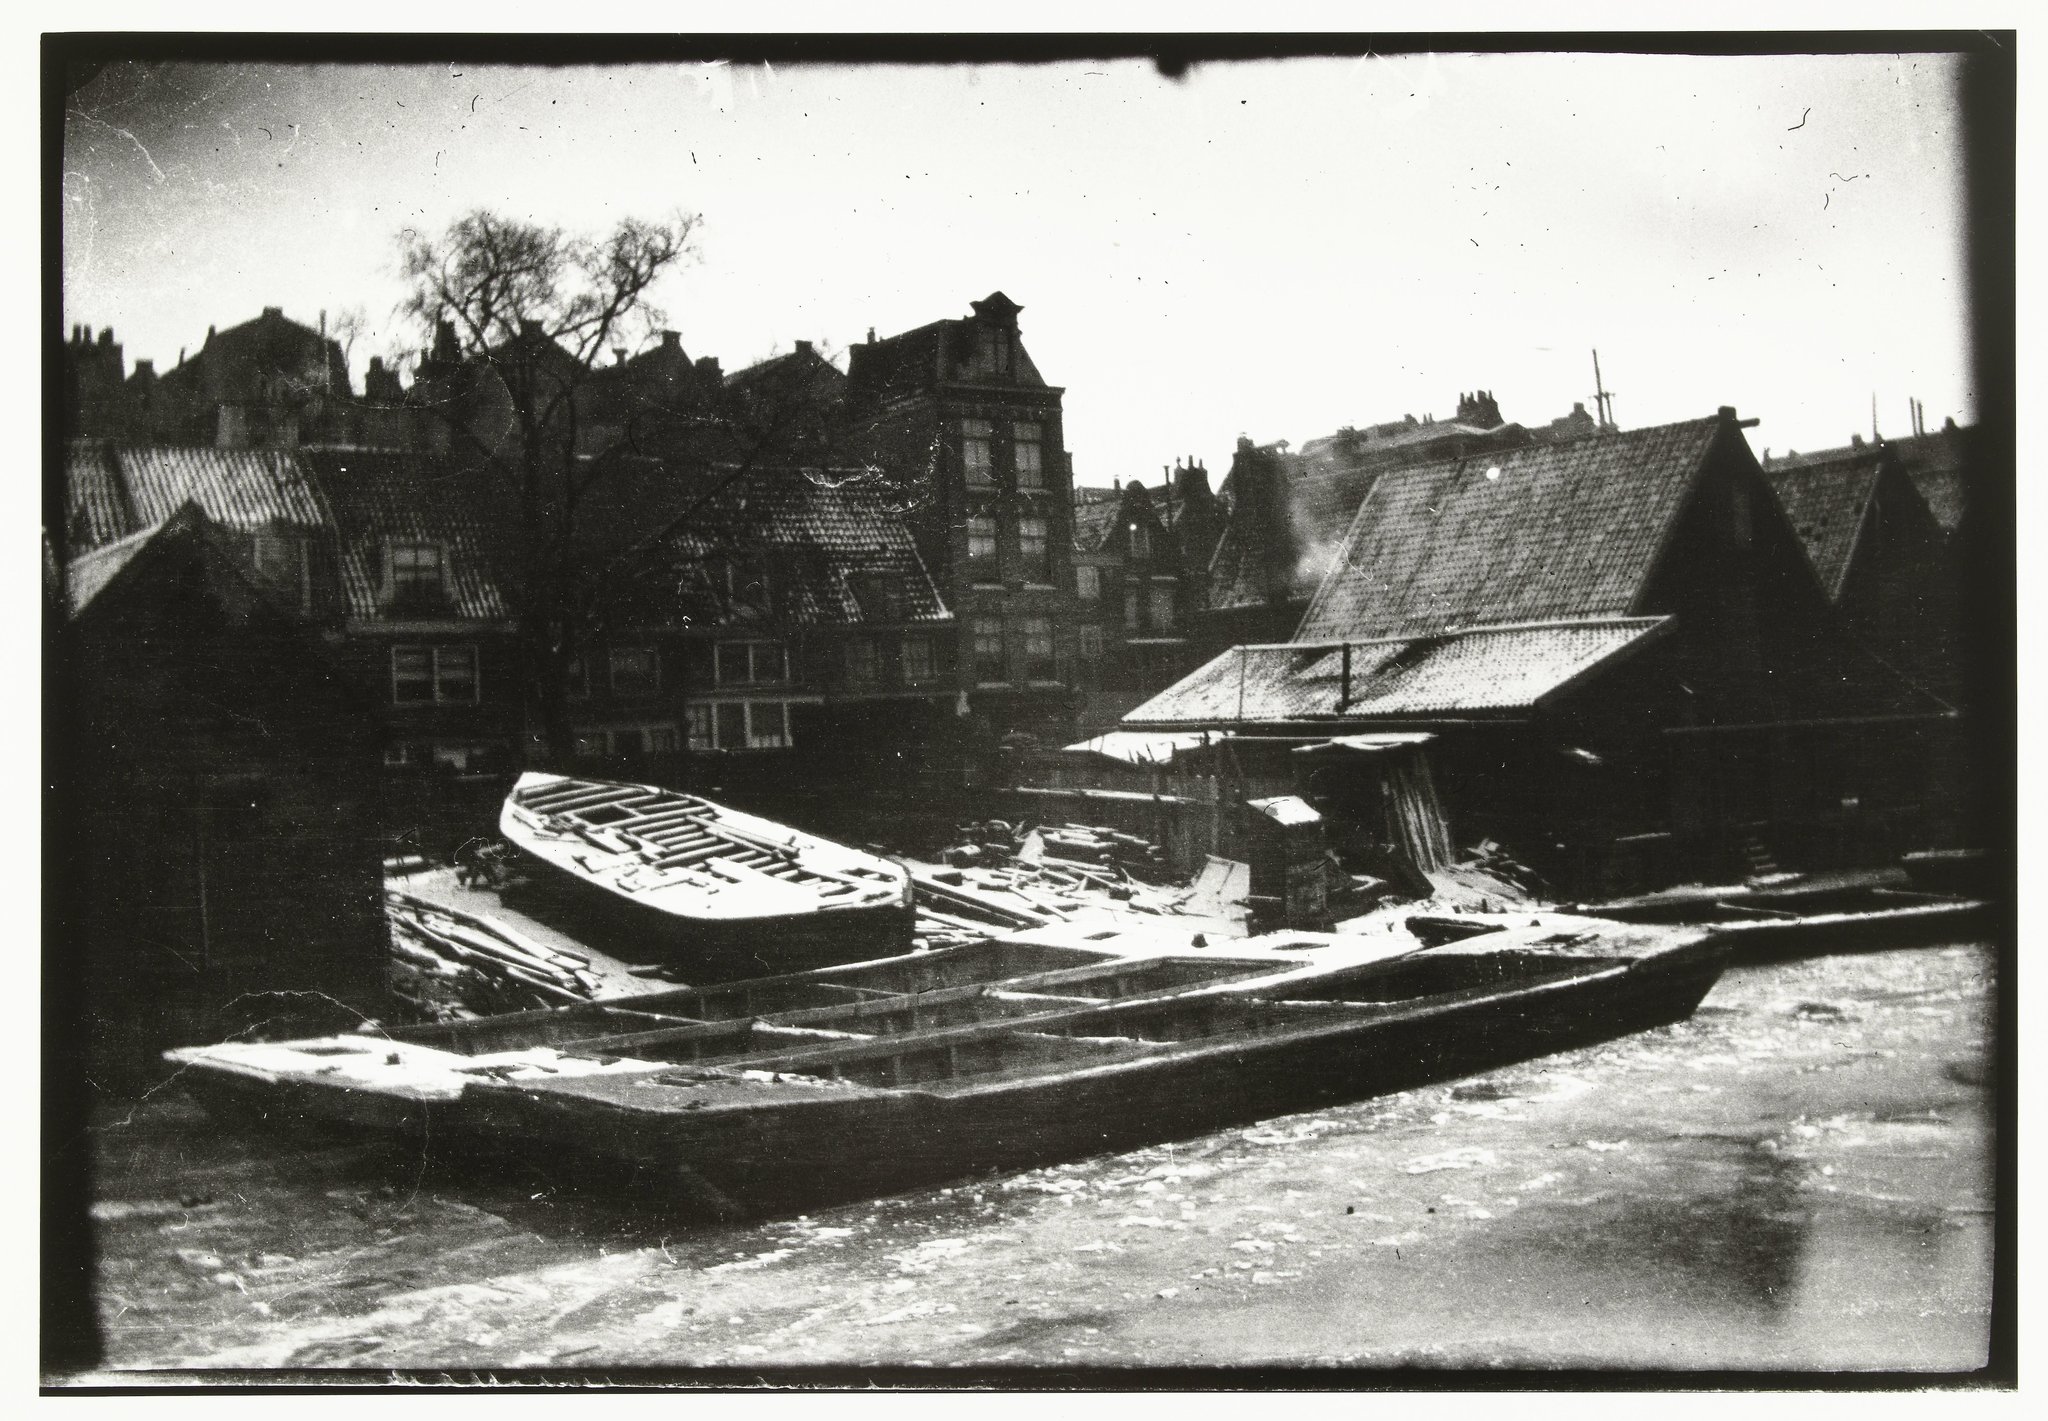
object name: photograph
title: Gezicht op een scheepswerf op het Prinseneiland in Amsterdam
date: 1890-1910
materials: paper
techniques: gelatin silver print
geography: amsterdam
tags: prinseneiland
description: Moderne afdruk van negatief BR 519 (collectie RKD).